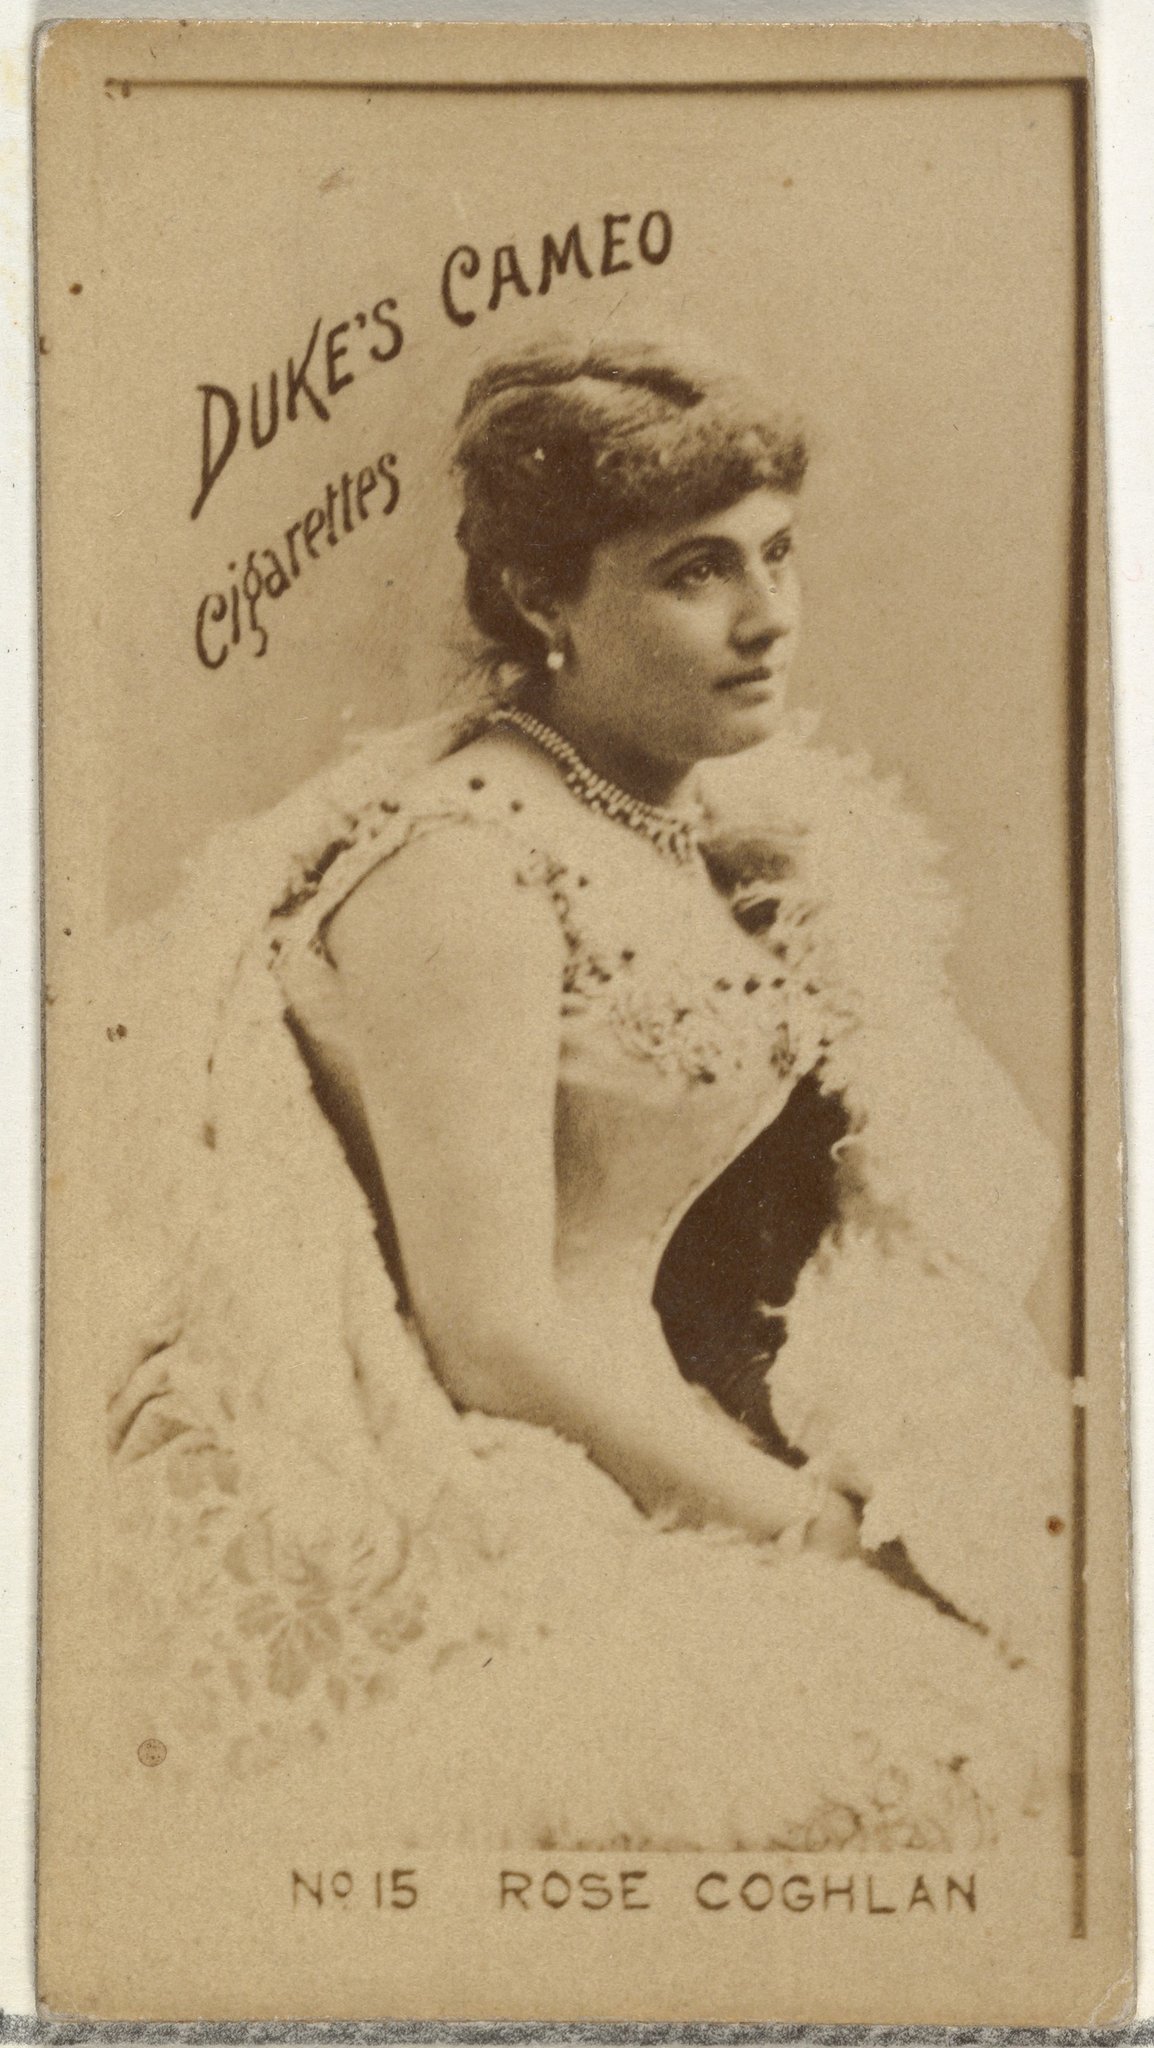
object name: photograph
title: Card Number 15, Rose Coghlan, from the Actors and Actresses series (N145-4) issued by Duke Sons & Co. to promote Cameo Cigarettes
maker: w. duke, sons & co.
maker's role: publisher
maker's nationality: american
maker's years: 1870-1920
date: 1880-1889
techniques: albumen silver print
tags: portraits,women,actresses